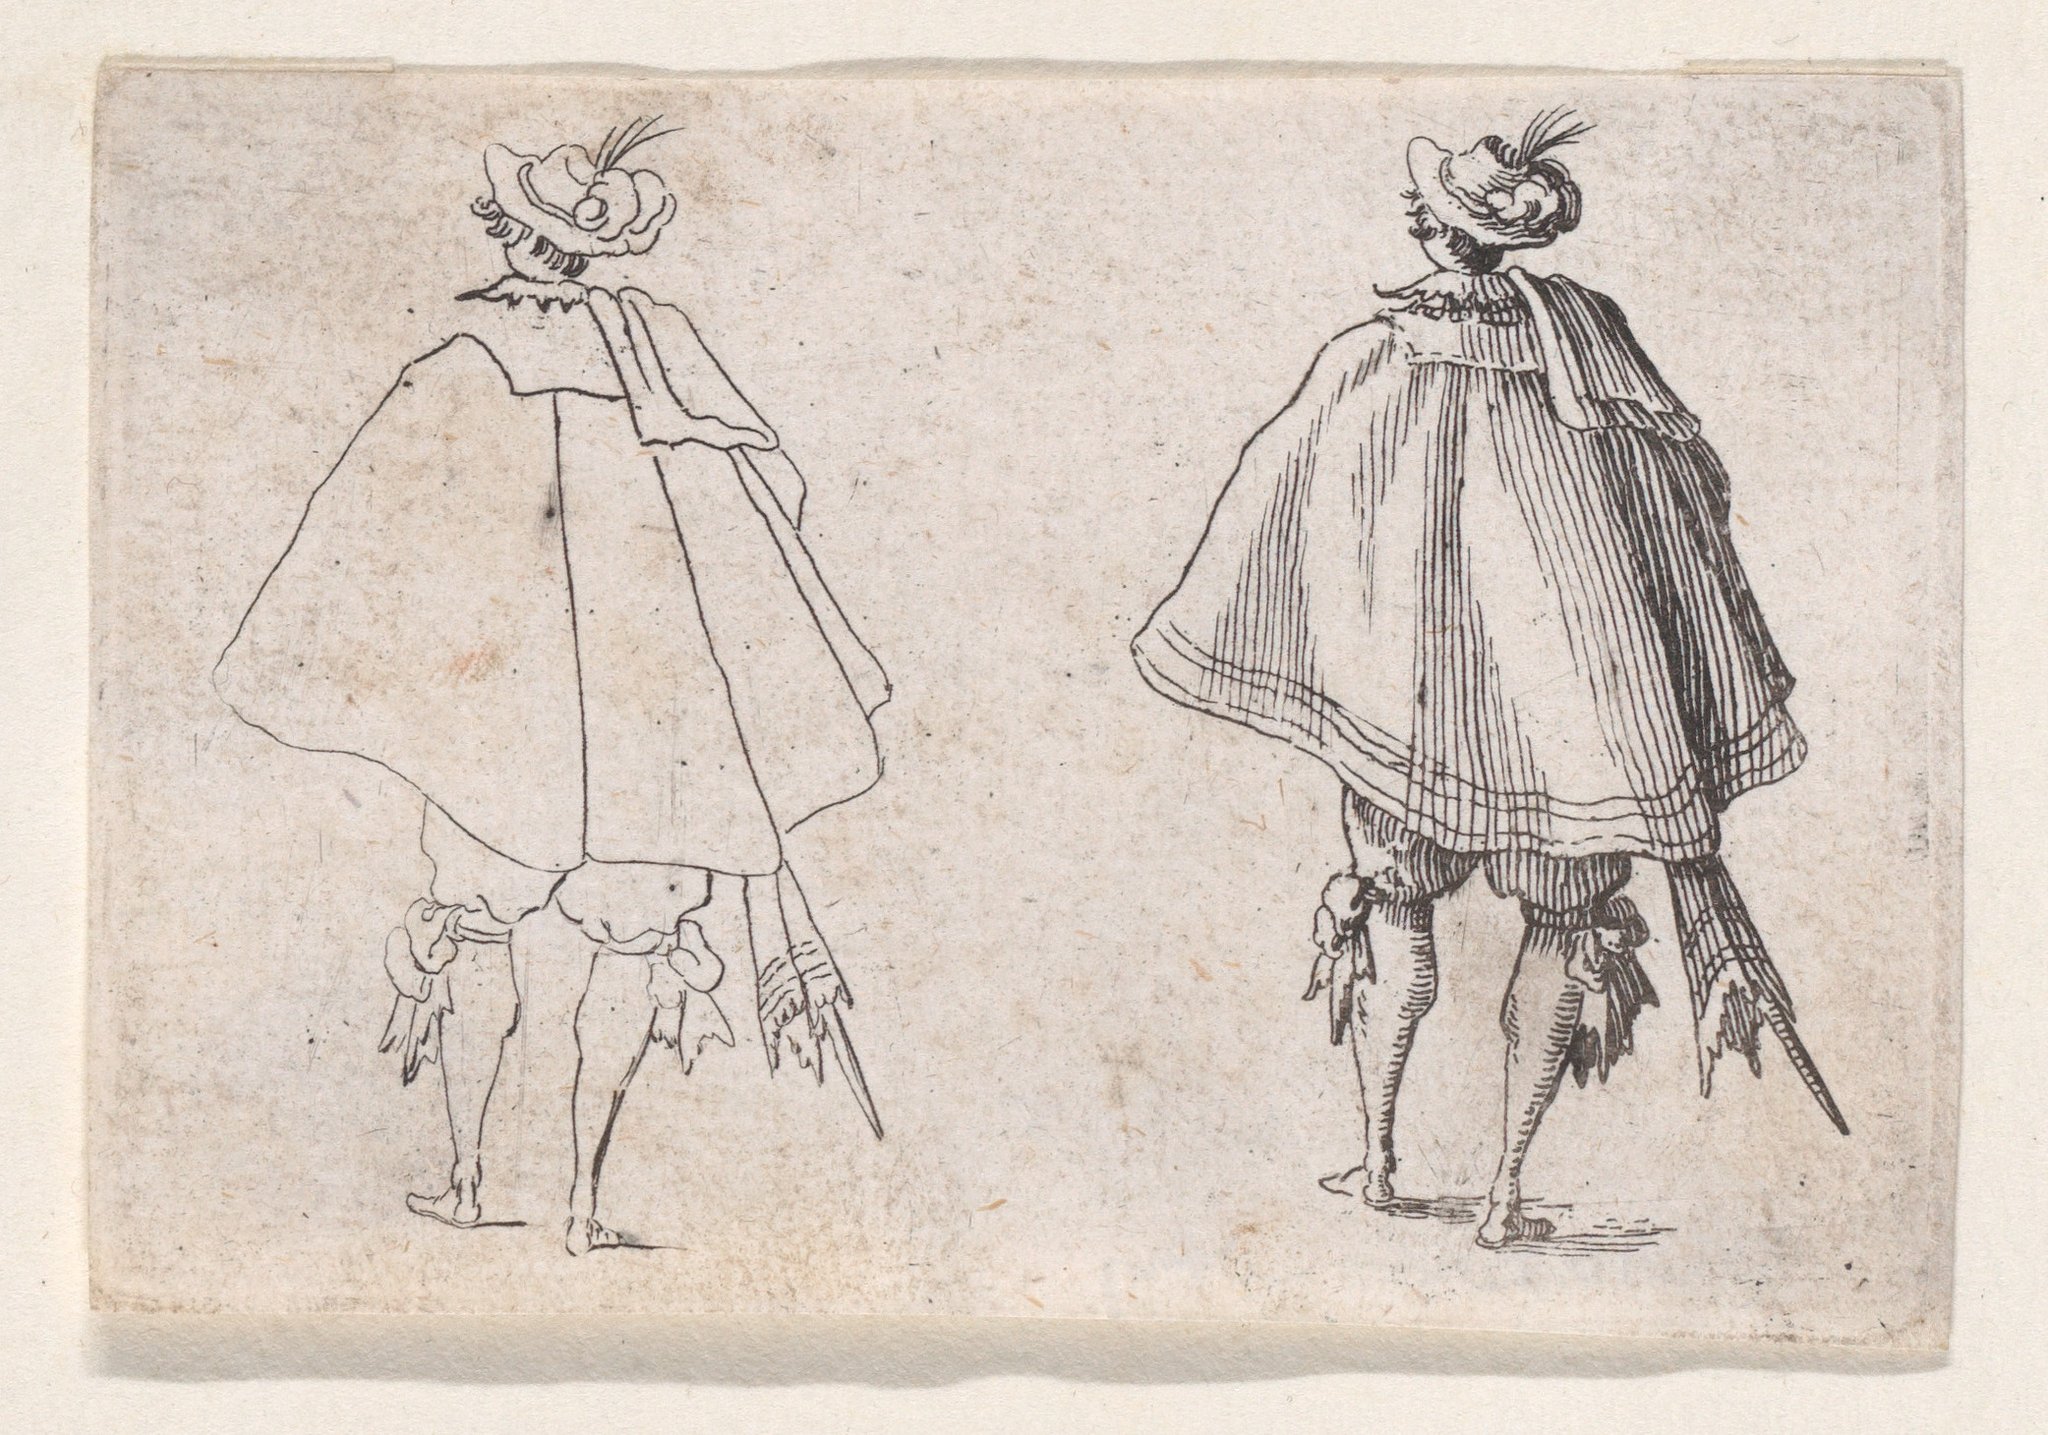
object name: print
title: Reverse Copy of Le Gentilhomme au Grand Manteau, Vu de Dos (Gentleman with a Large Mantle, Viewed from Behind), from "Les Caprices" Series A, The Florence Set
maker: Anonymous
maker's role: artist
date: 1601-1700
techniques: etching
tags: men